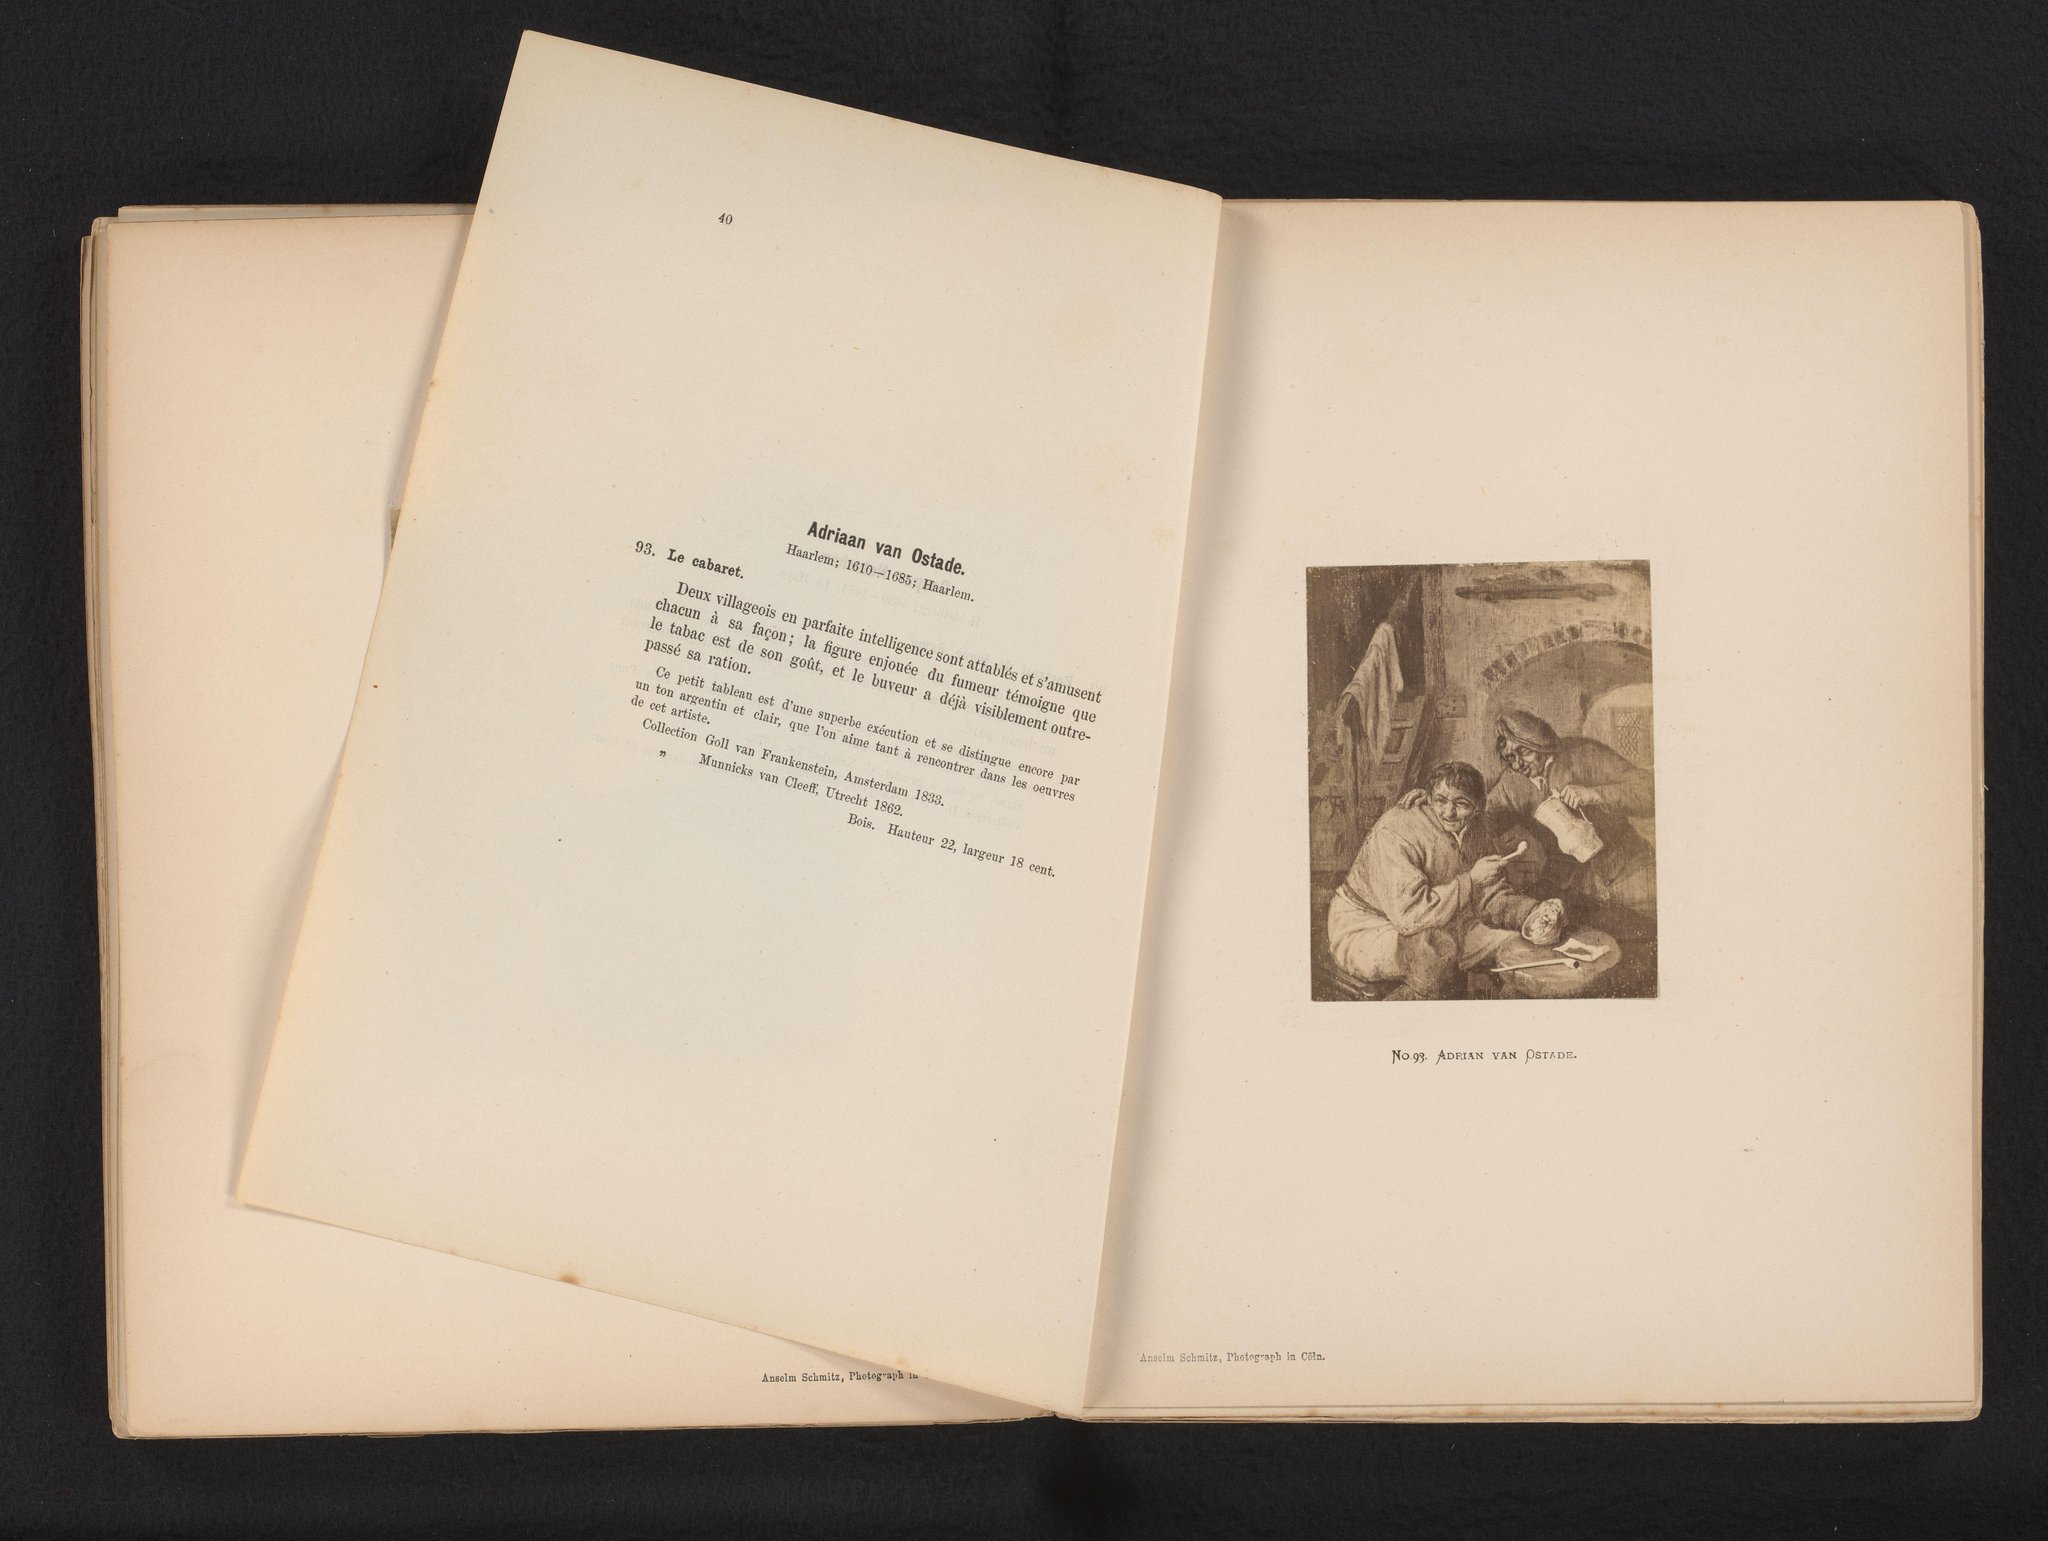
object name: page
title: Fotoreproductie van een schilderij van twee mannen die roken en drinken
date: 1871-1876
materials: photographic support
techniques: albumen print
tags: pipe ~ tobacco, drinking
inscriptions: inscription: ‘No. 93. Adrian van Ostade’